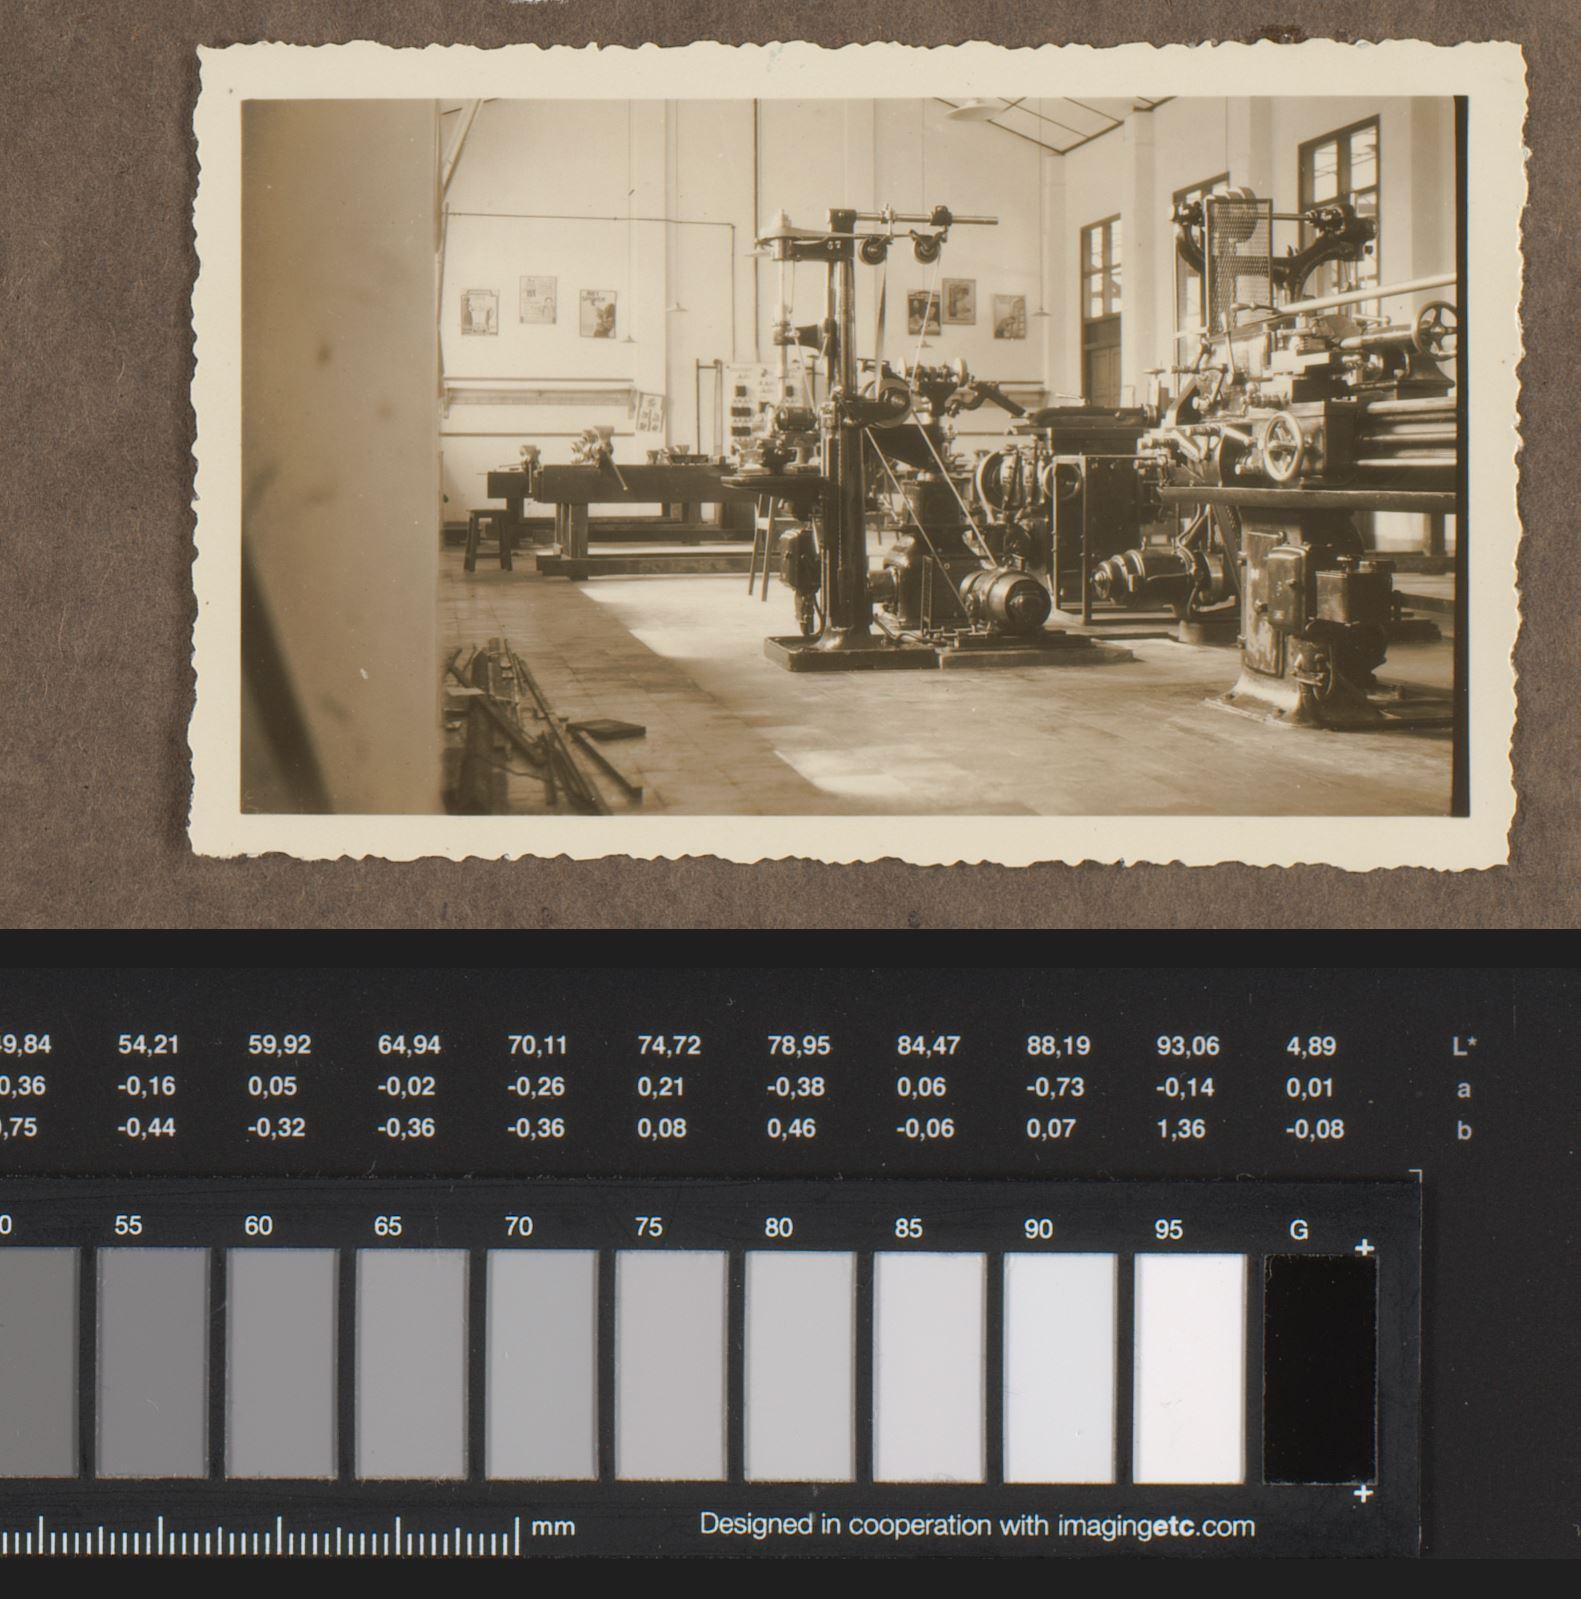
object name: photograph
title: Draaibanken van de Technische School te Bandoeng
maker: Anonymous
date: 1933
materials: photographic support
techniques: gelatin silver print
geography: bandung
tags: vocational education, e.g.: junior technical school, colonial government, dutch east indies, the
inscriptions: inscription: ‘Bankwerkeryen / TS’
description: Draaibanken in de werkplaats van de Technische School te Bandoeng. Foto ingeplakt in het fotoalbum aangeboden aan J.H.A. van der Hoeven bij het beëindigen op 31 juli 1933 van zijn diensttijd bij het Nijverheidsonderwijs in Nederlandsch-Indië.